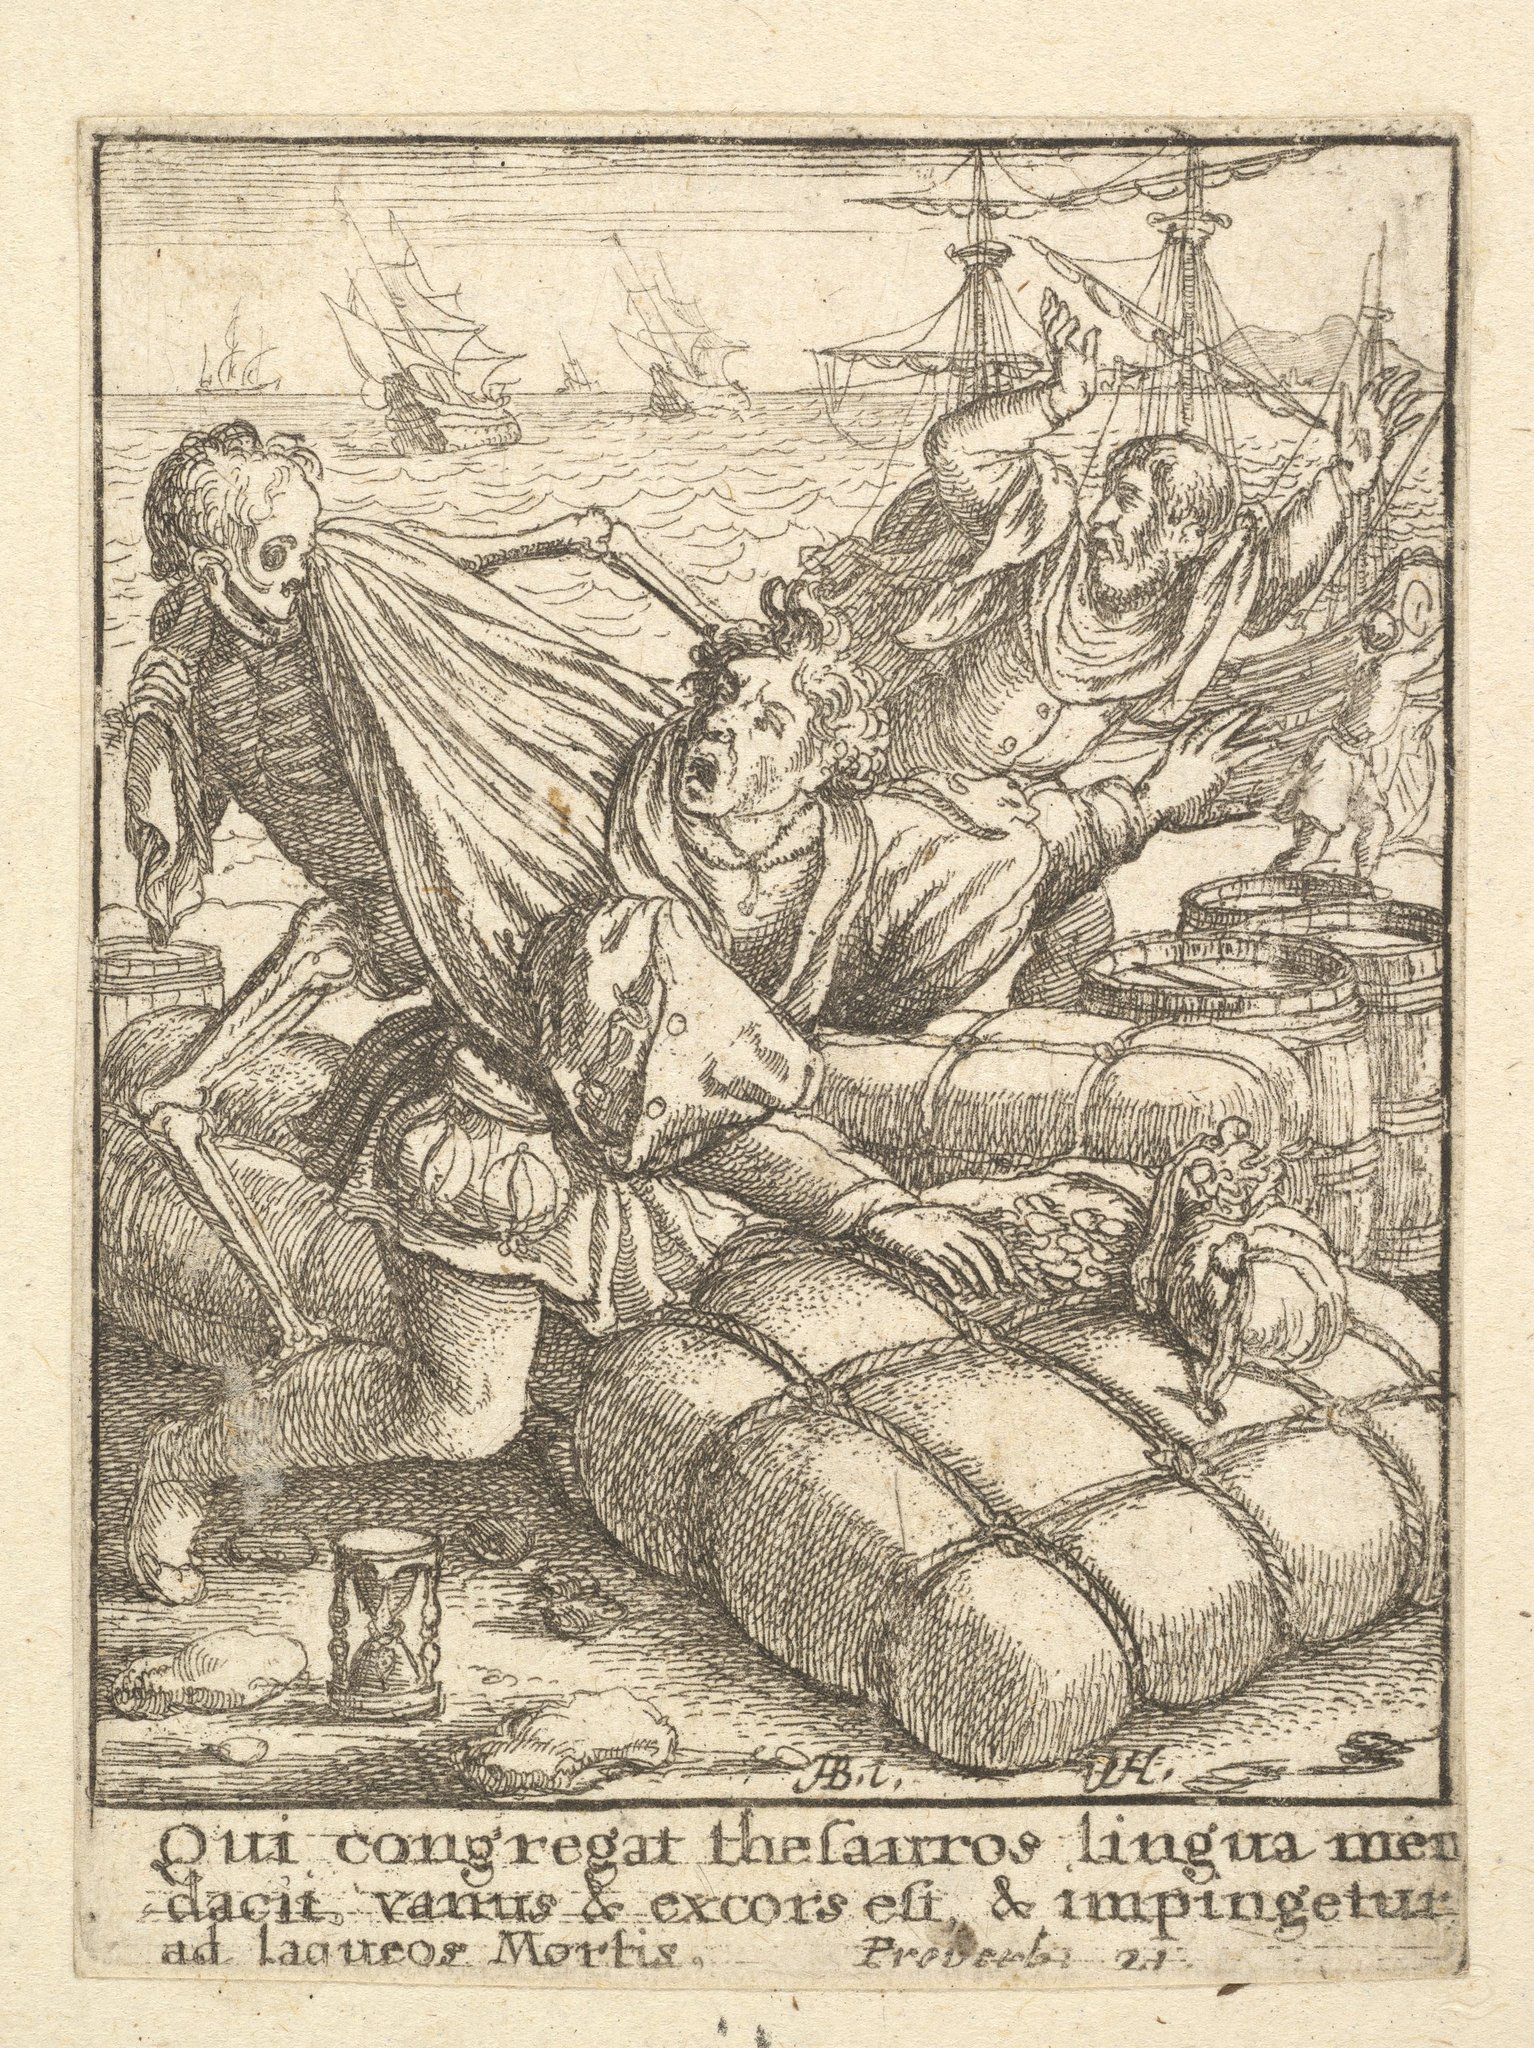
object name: print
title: The Merchant, from the Dance of Death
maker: wenceslaus hollar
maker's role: artist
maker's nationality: bohemian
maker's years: 1607-1677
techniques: etching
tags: skeletons,men,ships